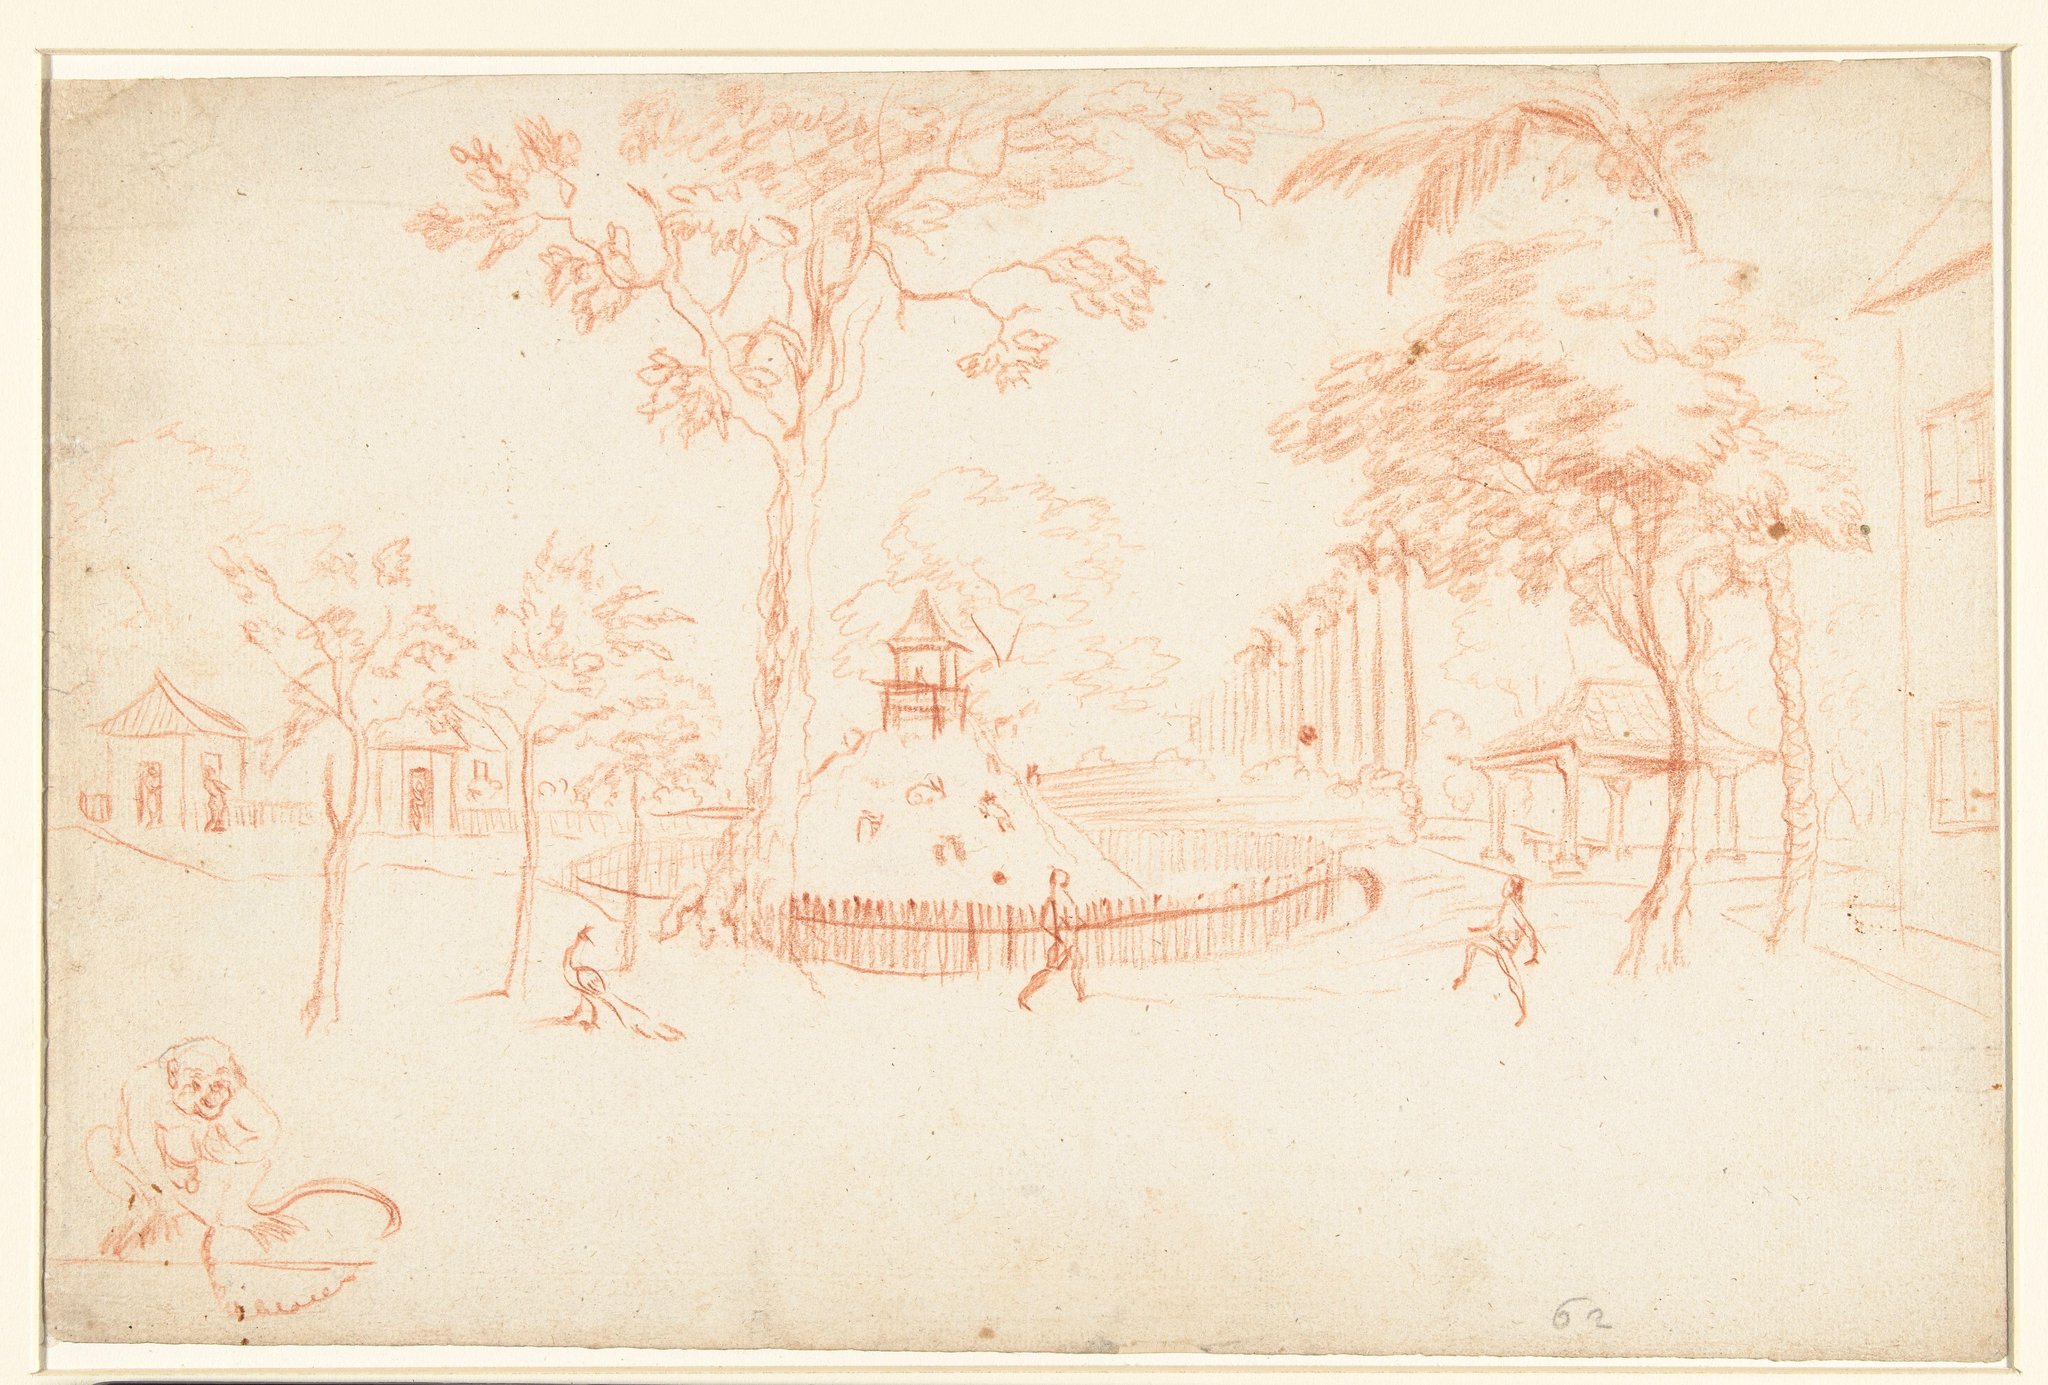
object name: drawing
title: Afrastering met kleine berg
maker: Anonymous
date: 1700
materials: chalk, paper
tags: monkeys, apes, dutch east indies, the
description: Afrastering met kleine berg waarin konijnen huizen, op de voorgrond een aap.